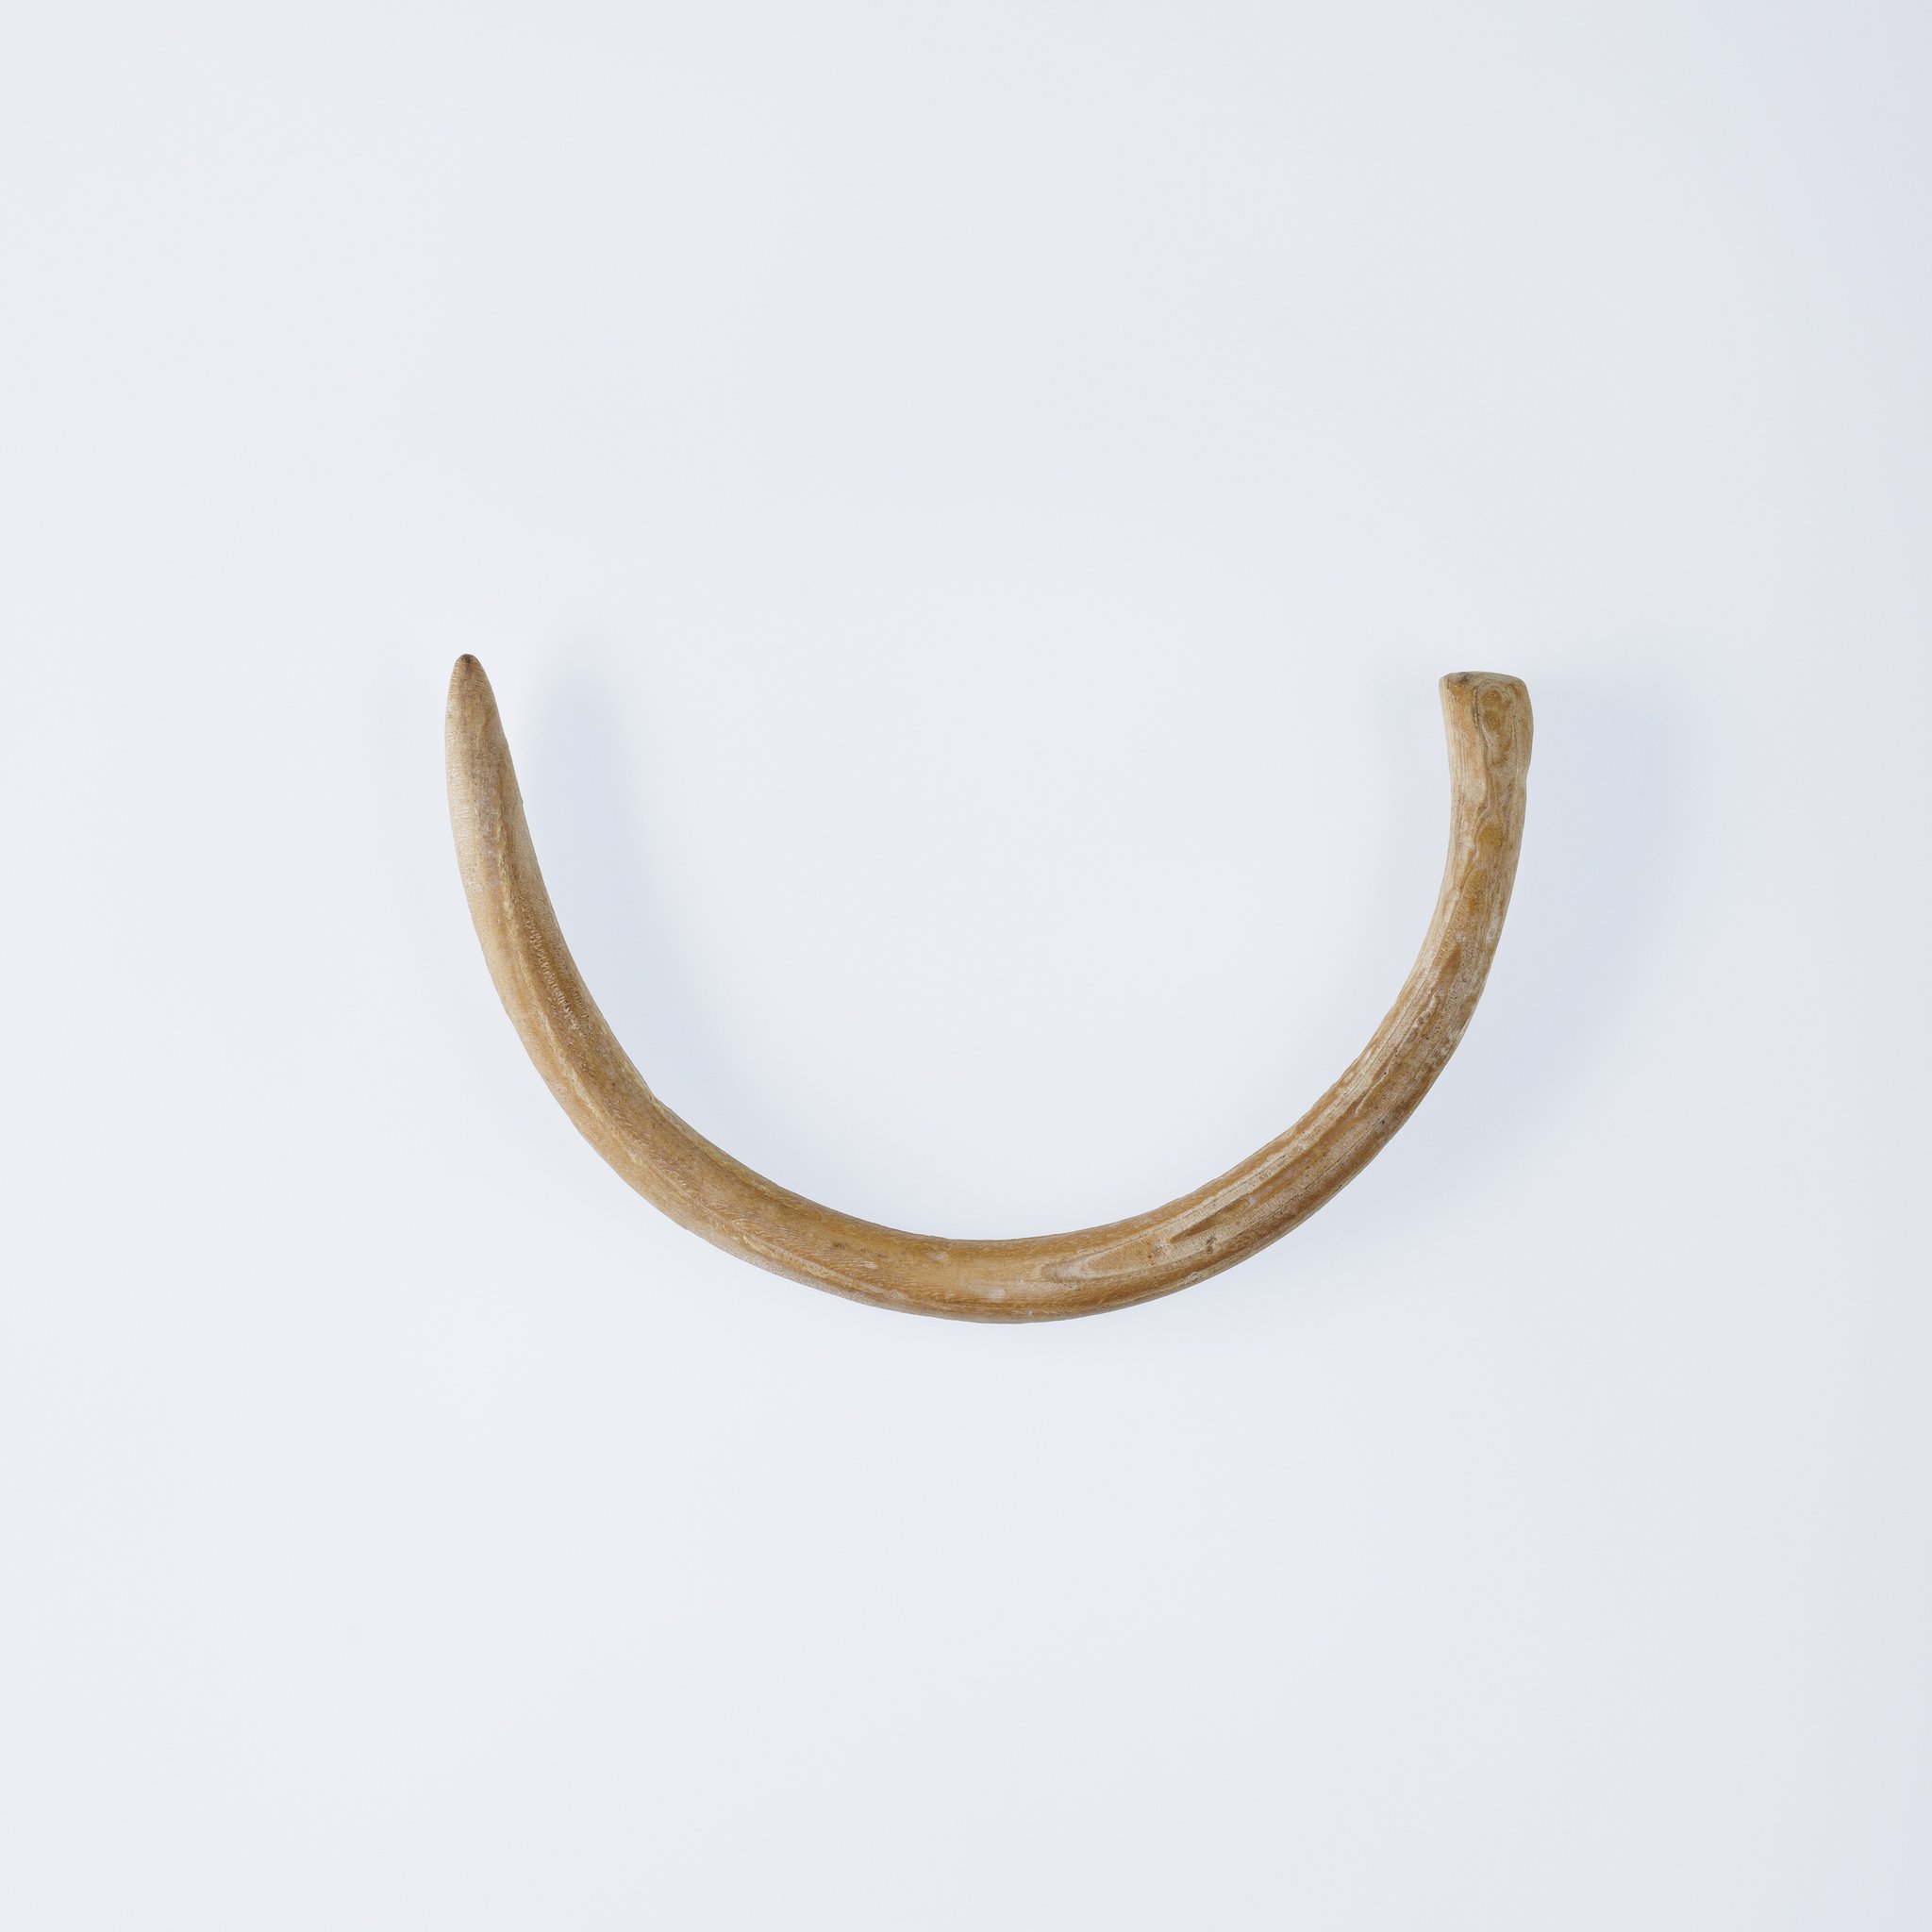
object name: bracelet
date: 4500-4000 BCE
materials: shell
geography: egypt